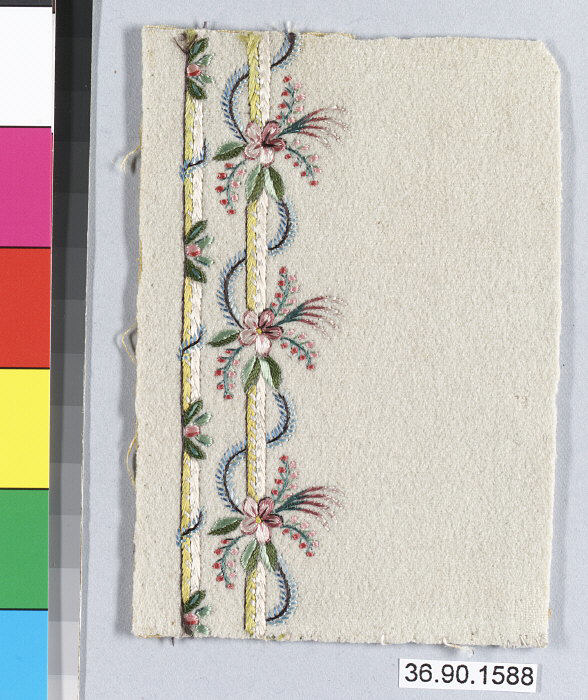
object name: sample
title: Embroidery sample for a man’s suit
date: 1785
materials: silk, wool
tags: flowers